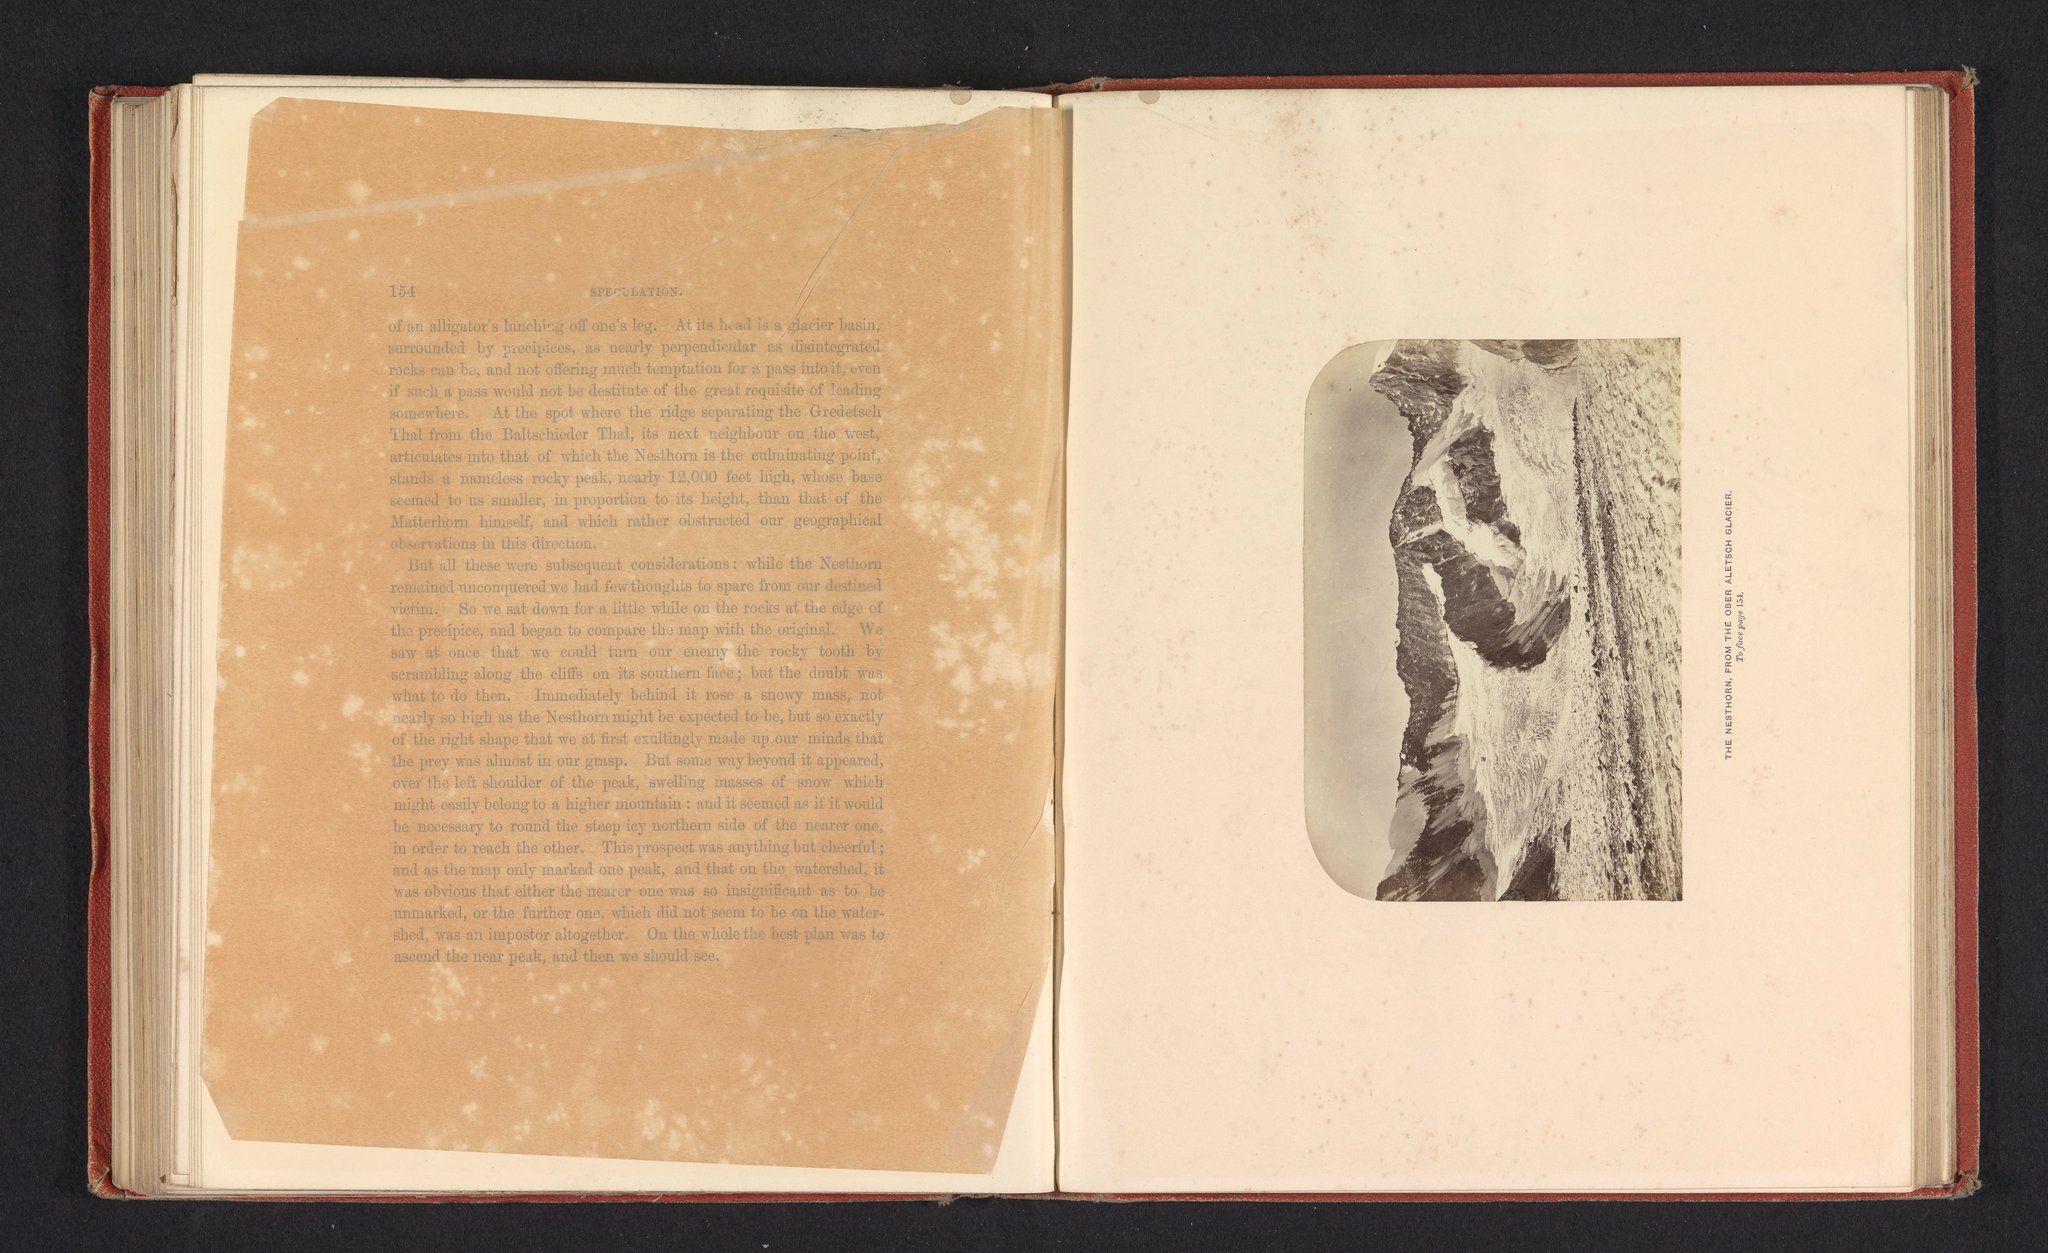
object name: page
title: The Nesthorn, from the Ober Aletsch glacier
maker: ernest edwards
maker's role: fotograaf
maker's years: 1837-1903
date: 1850-1866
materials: photographic support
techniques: albumen print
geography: bern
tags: glacier, mountain-range, snow peaks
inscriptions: inscription: ‘To face page 154.’